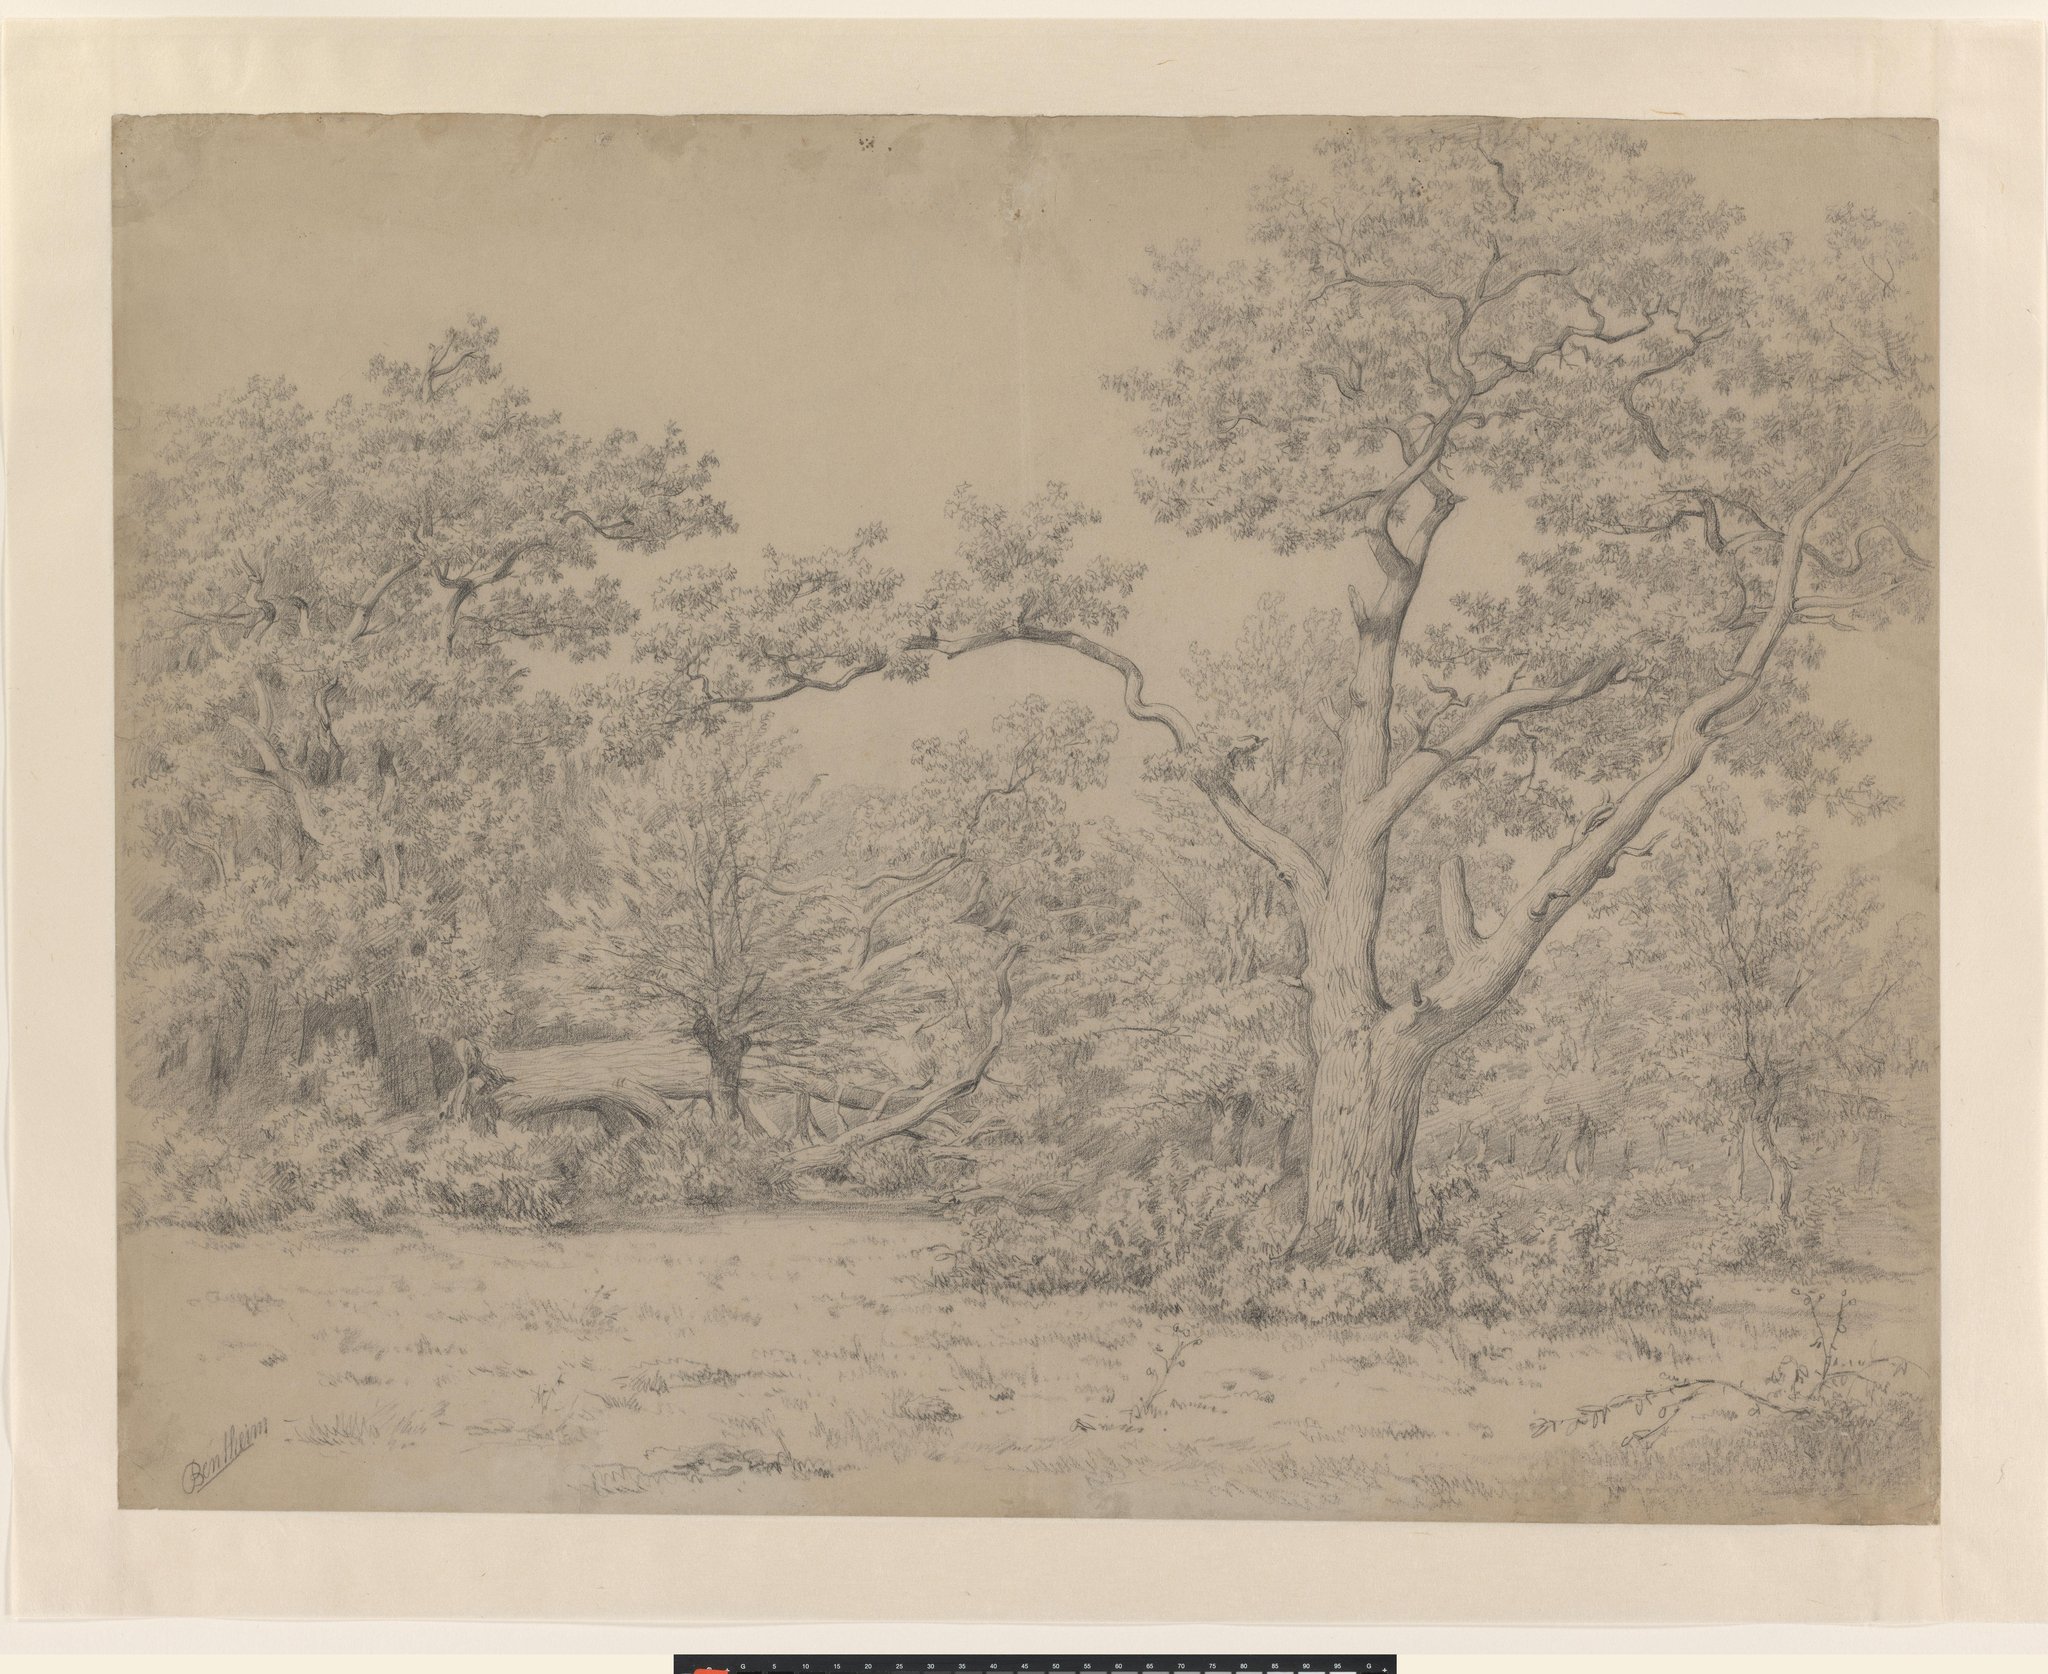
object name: drawing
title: Bosgezicht te Bentheim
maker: Anonymous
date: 1800-1900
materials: chalk, paper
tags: forest, wood, germany